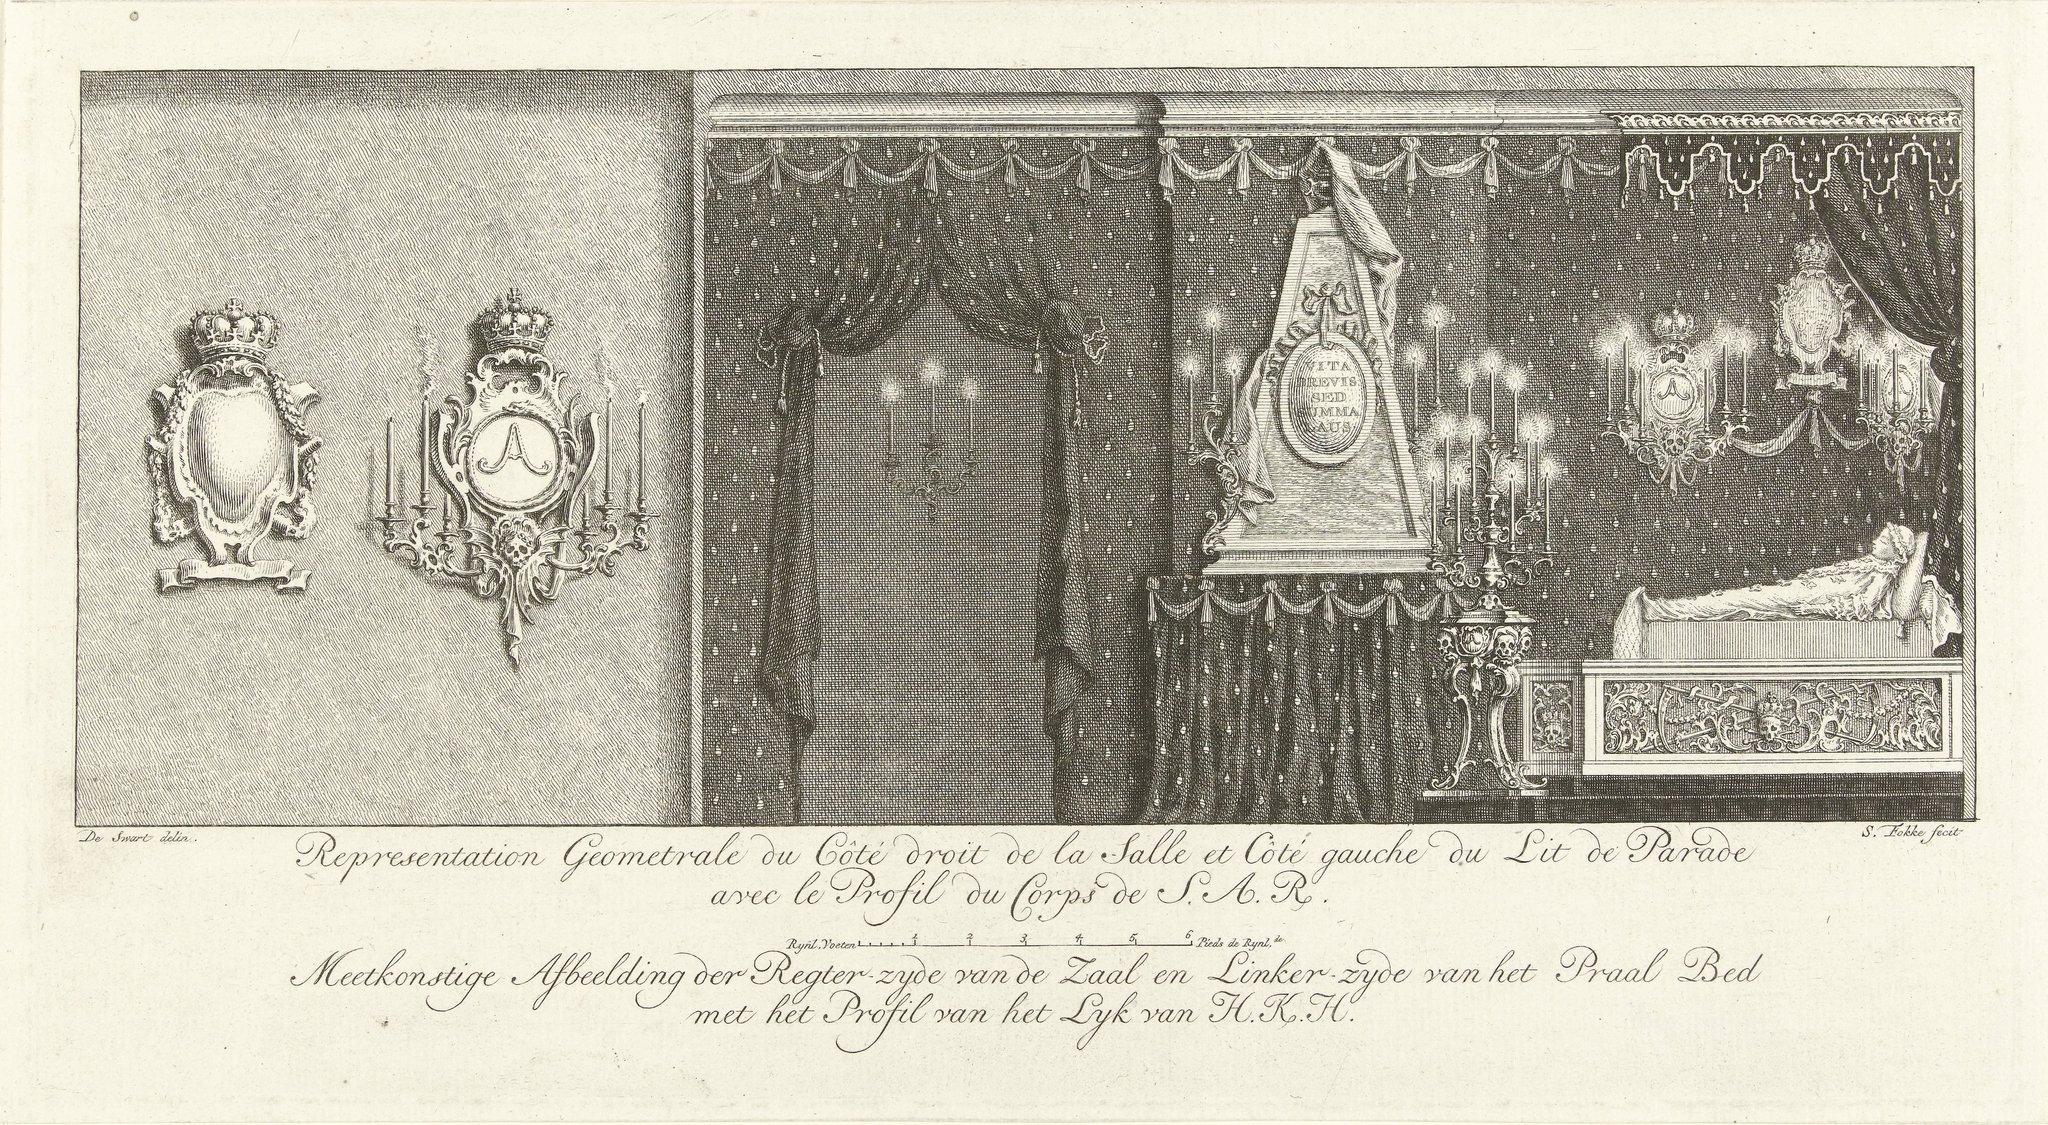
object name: print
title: Praalbed van prinses Anna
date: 1759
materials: paper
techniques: engraving, etching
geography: northern netherlands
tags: the hague, anna van hannover, lying in state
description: Paradezaal met zijaanzicht van het praalbed met het opgebaarde lijk van de prinses. Onderdeel van een serie van vier platen van het praalbed waarop de op 12 januari 1759 overleden prinses Anna van Hannover gedurende enkele dagen in februari opgebaard heeft gelegen.